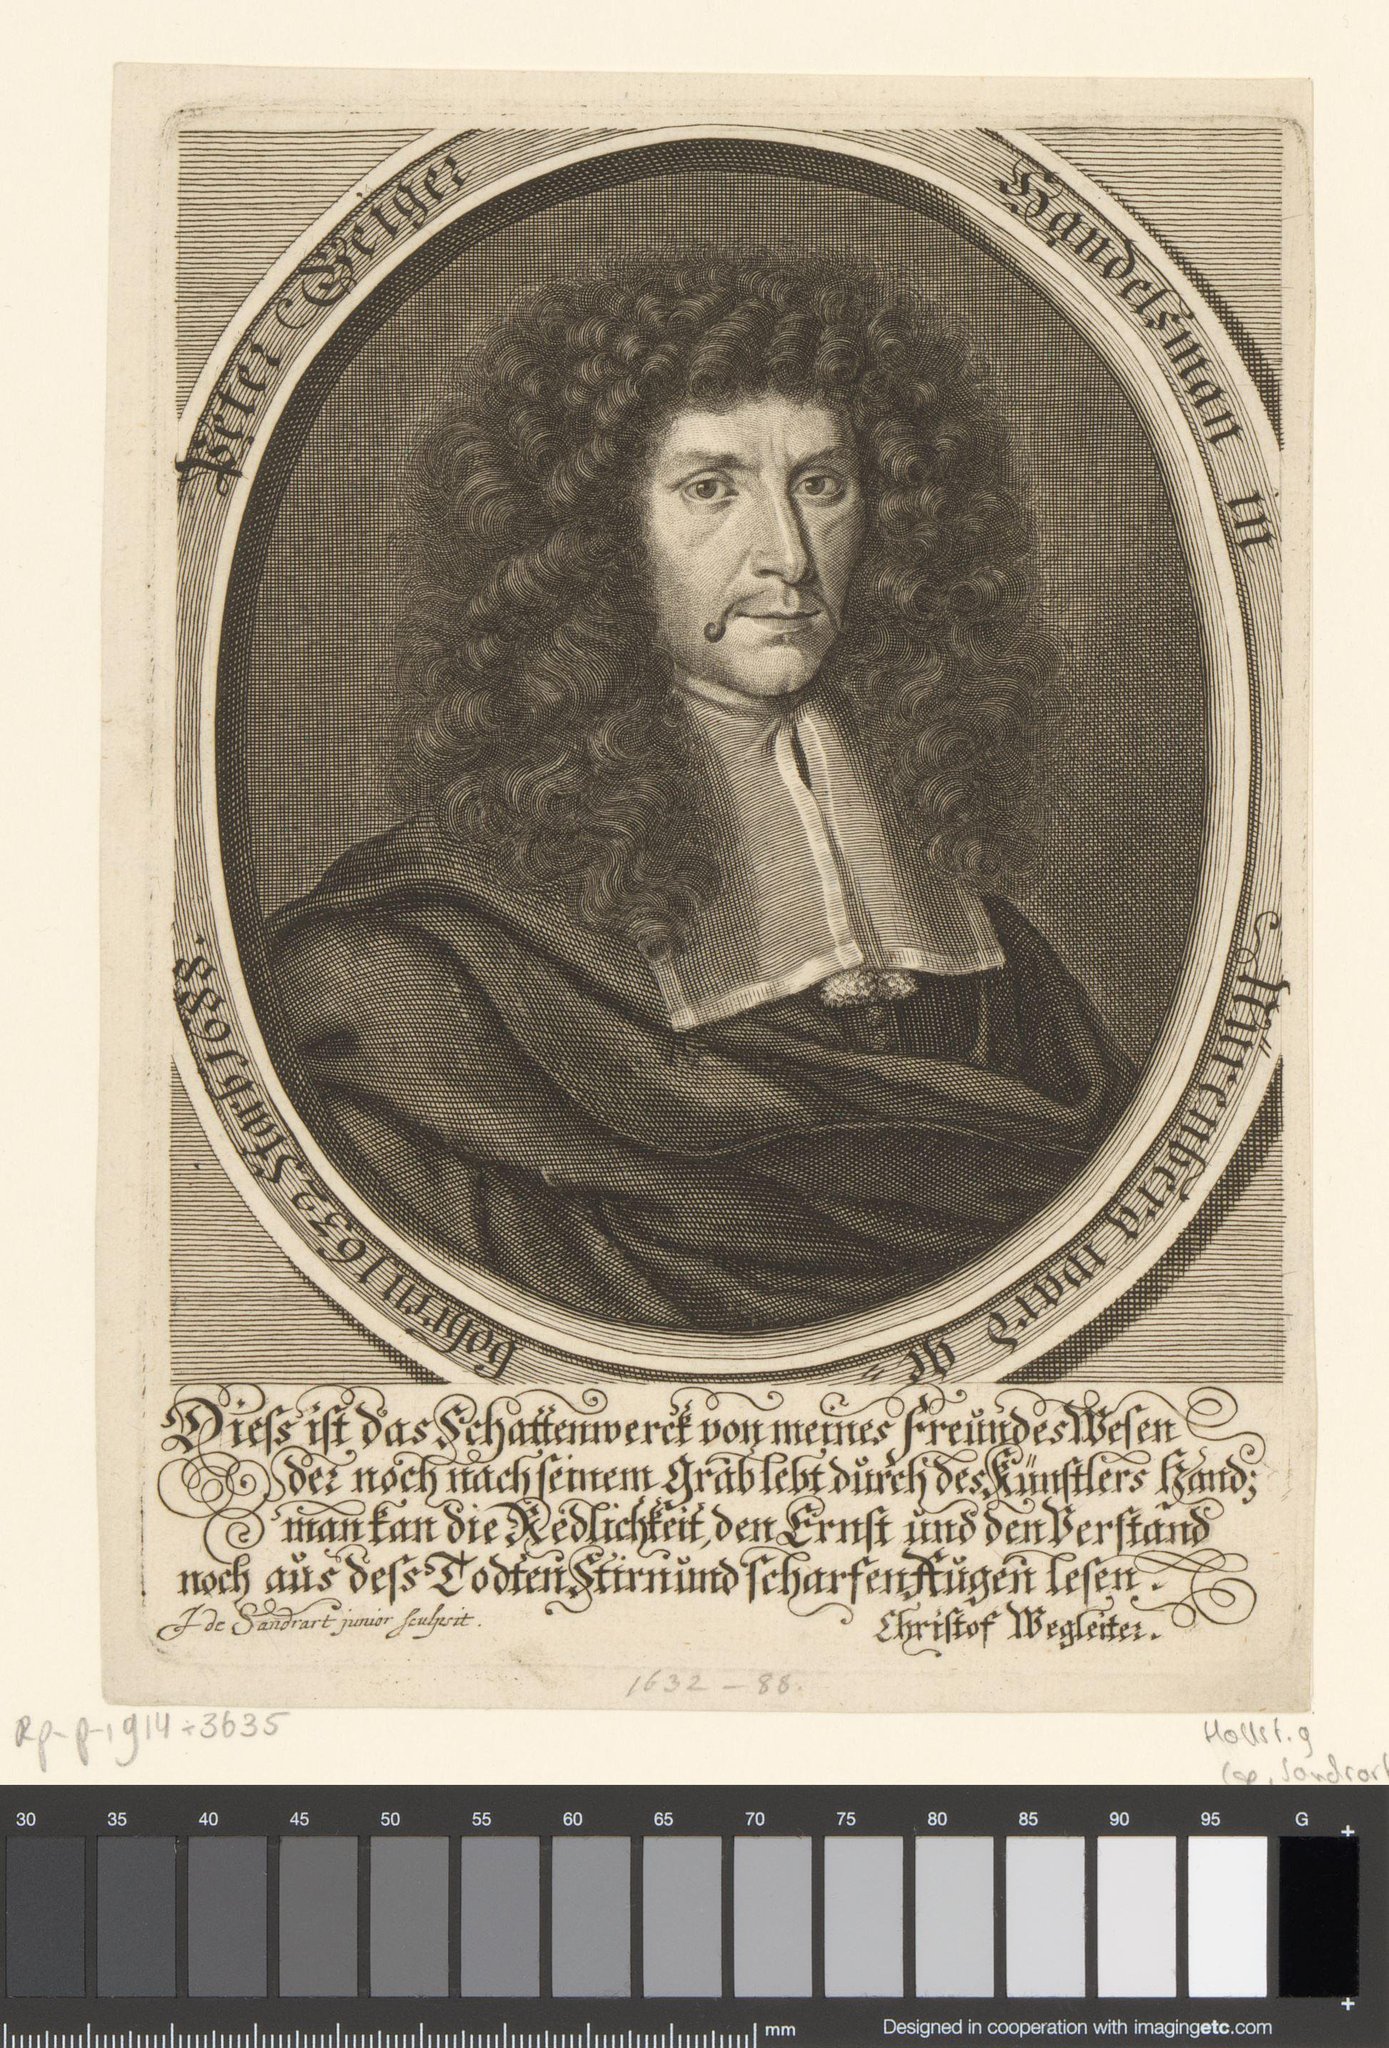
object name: print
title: Portret van Peter Geiger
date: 1688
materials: paper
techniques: engraving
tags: historical persons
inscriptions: collector's mark: Lugt 2228